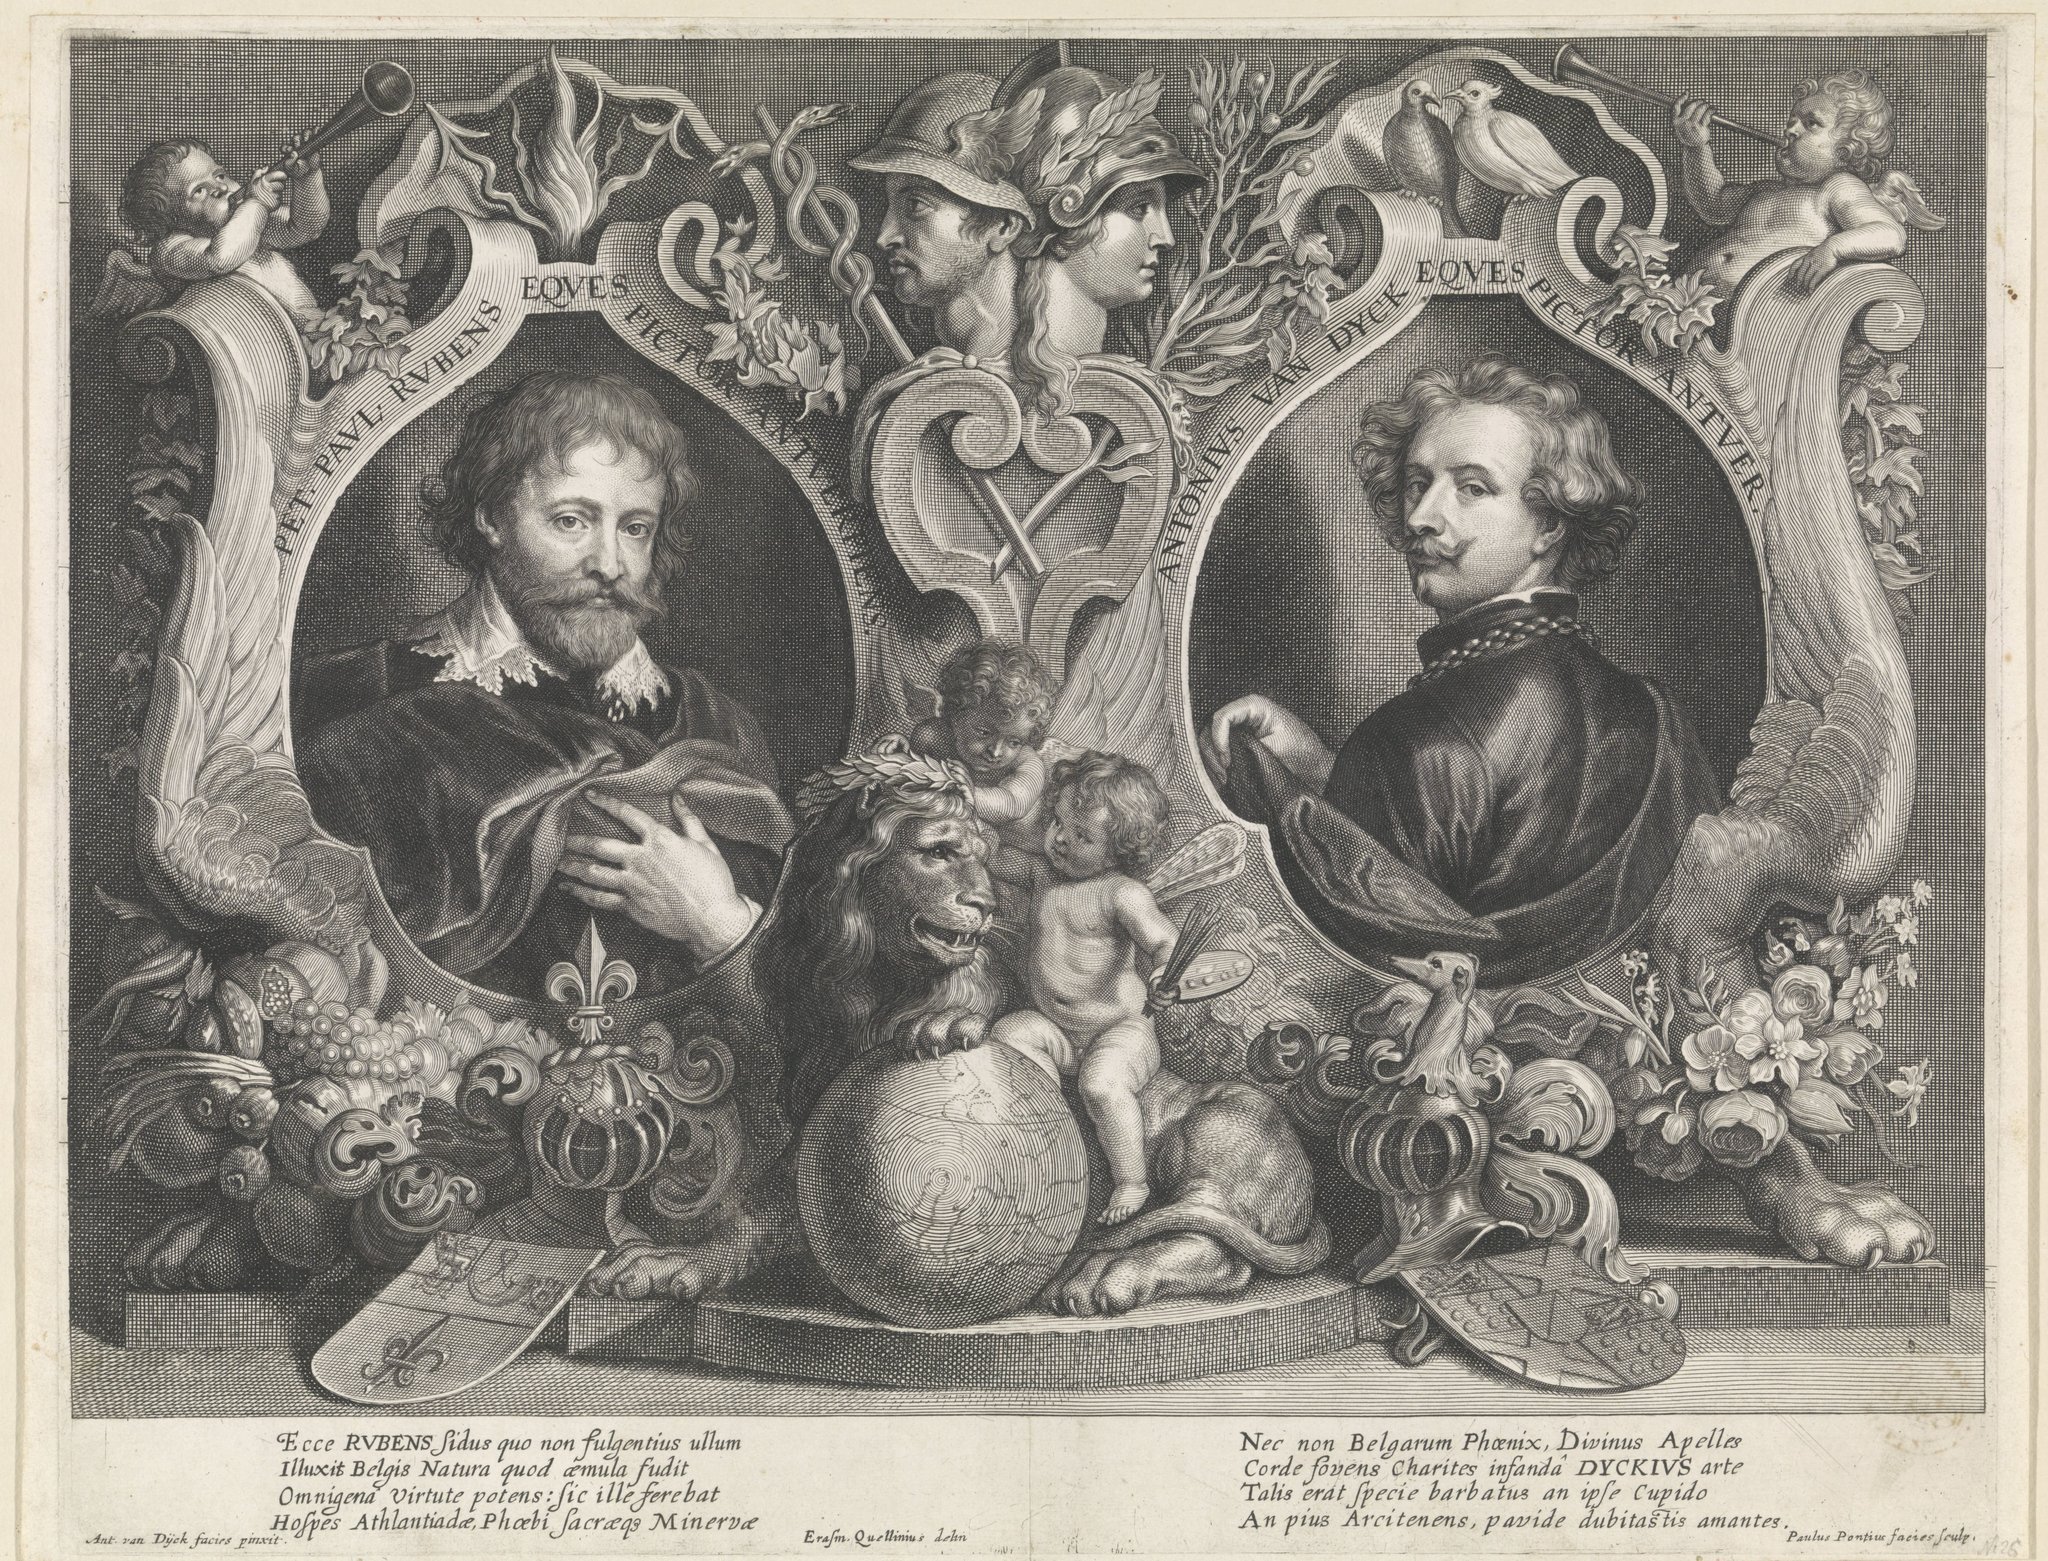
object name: print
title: Dubbelportret van de schilders Peter Paul Rubens en Anthony van Dyck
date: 1632-1658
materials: paper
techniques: engraving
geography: antwerp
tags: antwerp, painter, print maker, draughtsman, peter paul rubens, london, anthony van dyck, 'pictura', symbolic representations, allegories and emblems ~ painting; 'pittura' (ripa), portrait, self-portrait of painter, crowning with laurel, specific aspects, allegorical aspects of mercury; mercury as patron, specific aspects, allegorical aspects of apollo; apollo as patron, armorial bearing, heraldry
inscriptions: collector's mark: Lugt 240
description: Allegorisch dubbelportret van de schilders Peter Paul Rubens (links) en Anthony van Dyck (rechts). In het midden de koppen van Mercurius en Apollo. Op de voorgrond lauweren twee putti met schilderattributen een leeuw. In de marge onder elk portret een vierregelig lofdicht in het Latijn.